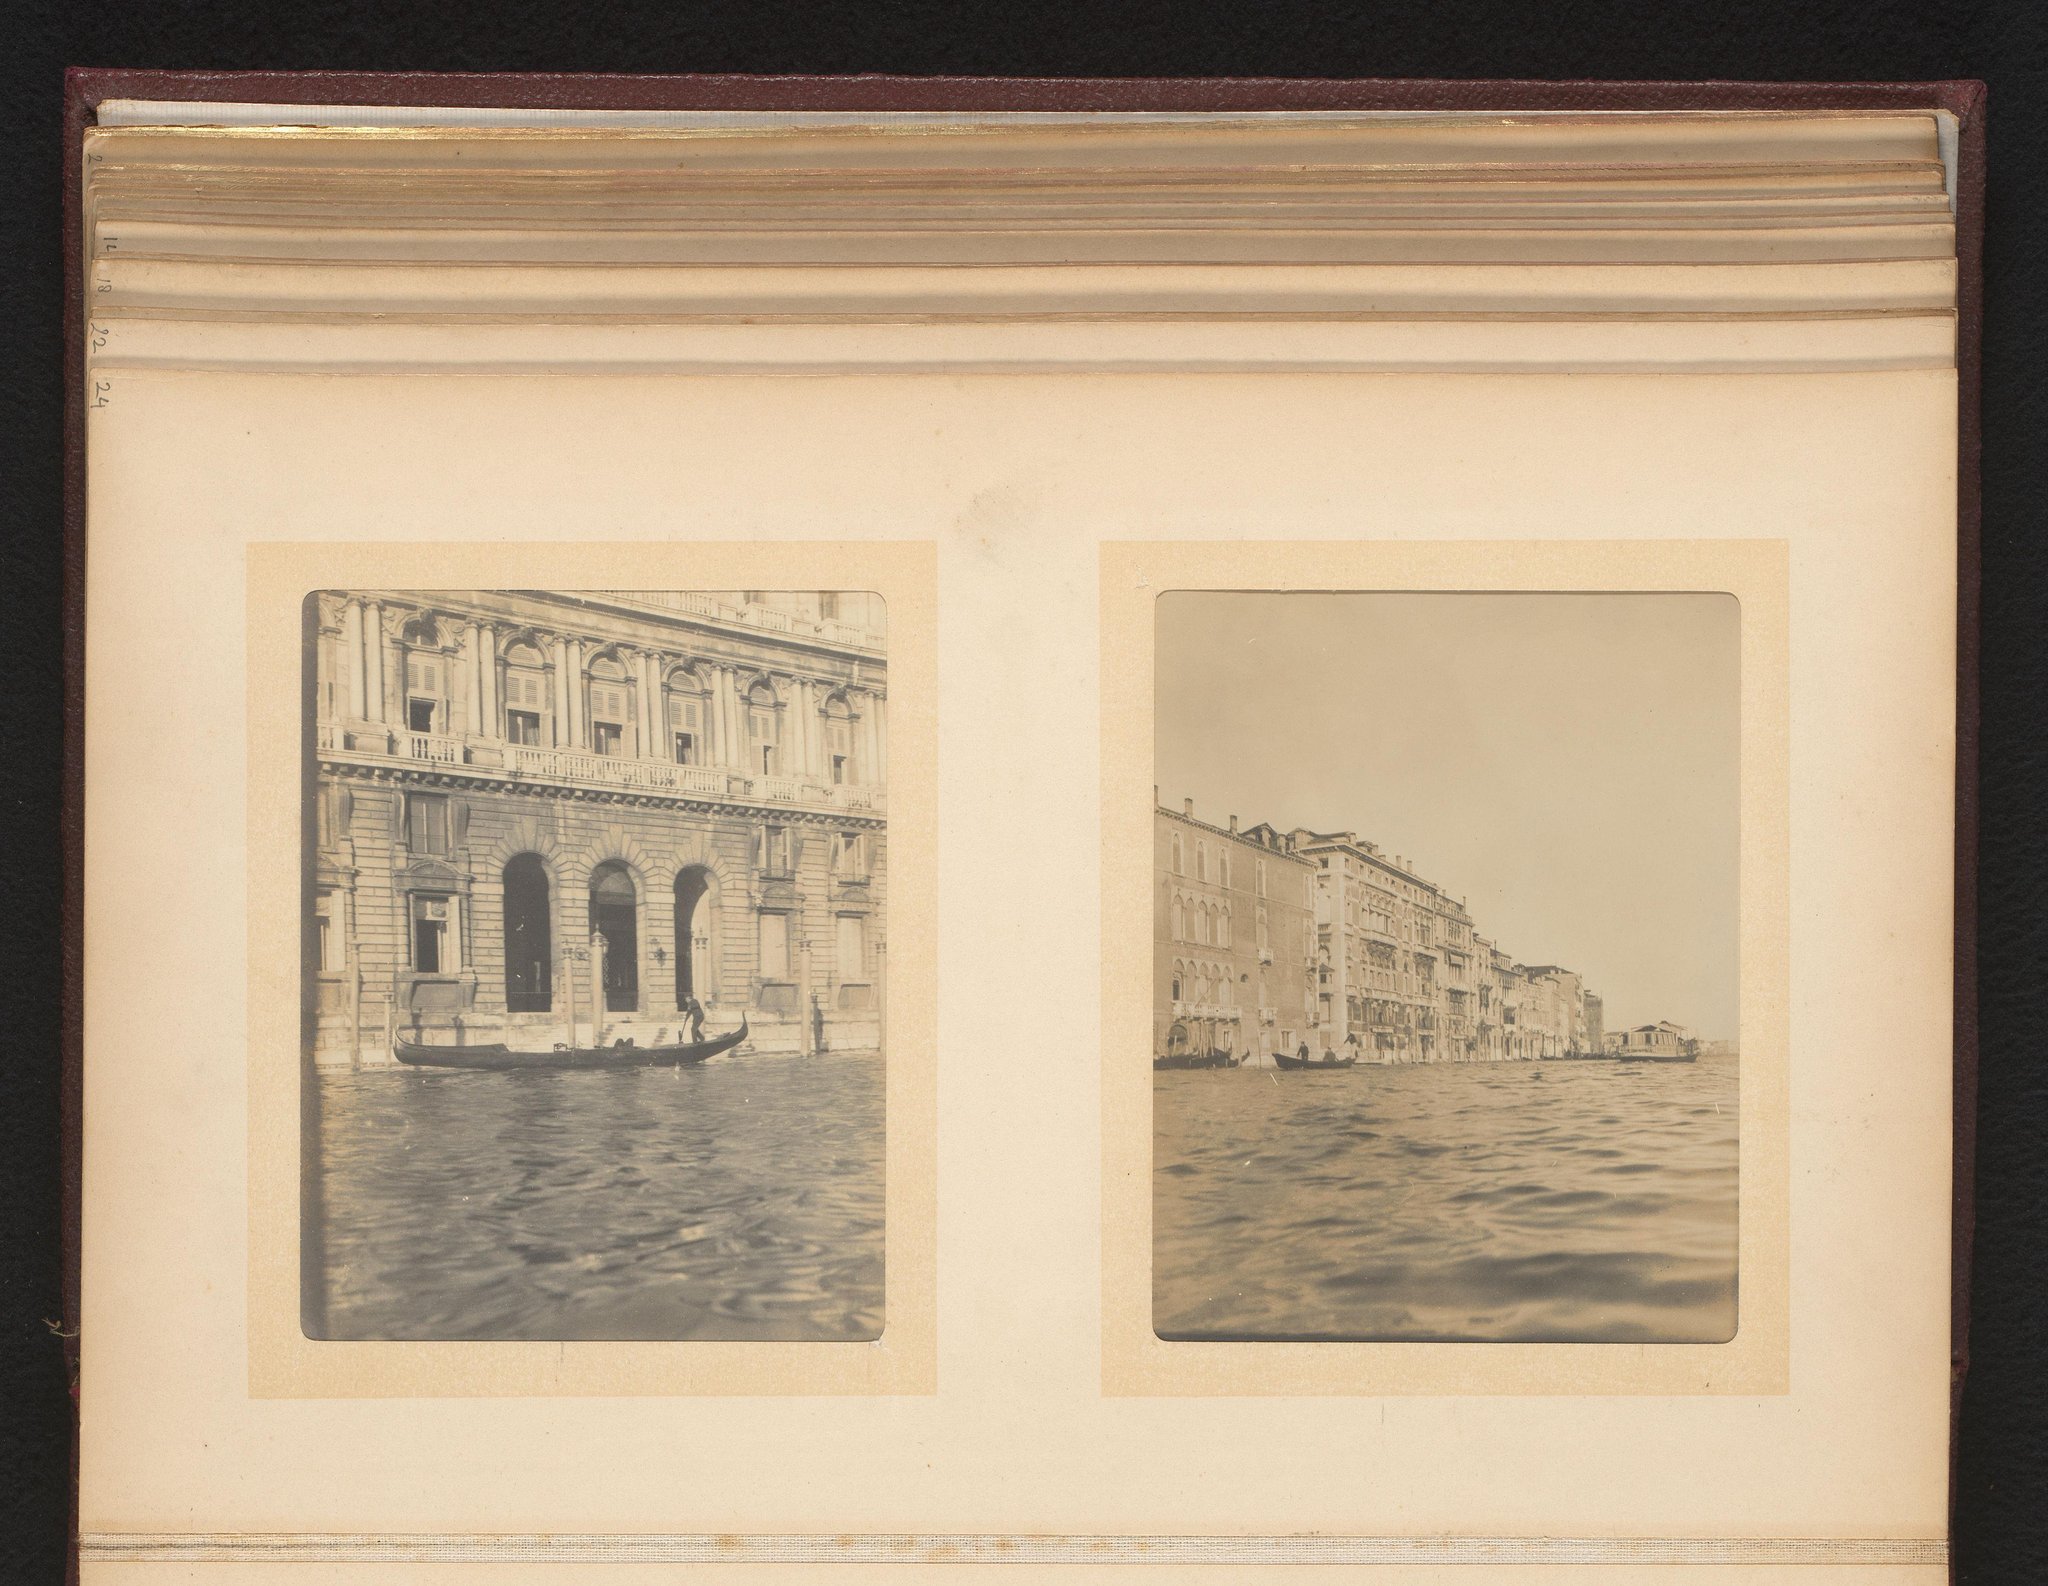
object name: photograph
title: Twee gezichten op gebouwen langs de kanalen van Venetië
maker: Anonymous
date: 1895-1905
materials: cardboard, photographic support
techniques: gelatin silver print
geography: venice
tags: tourism, canals, waters (in city), venice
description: Albumblad met twee foto's in Venetië. Onderdeel van een fotoalbum van een reis door Italië, ca. 1900.